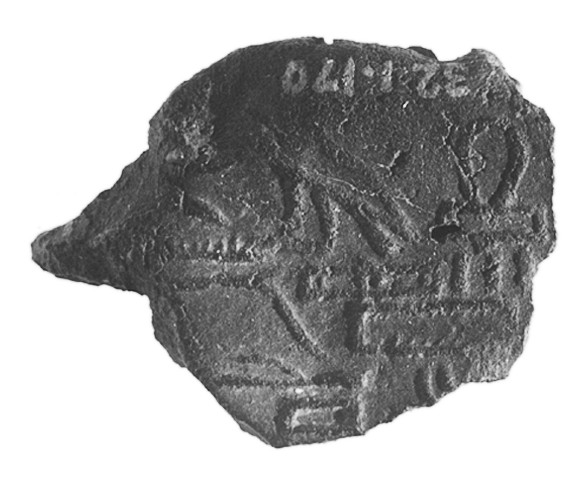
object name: sealing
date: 2030-1640 BCE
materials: clay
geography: egypt